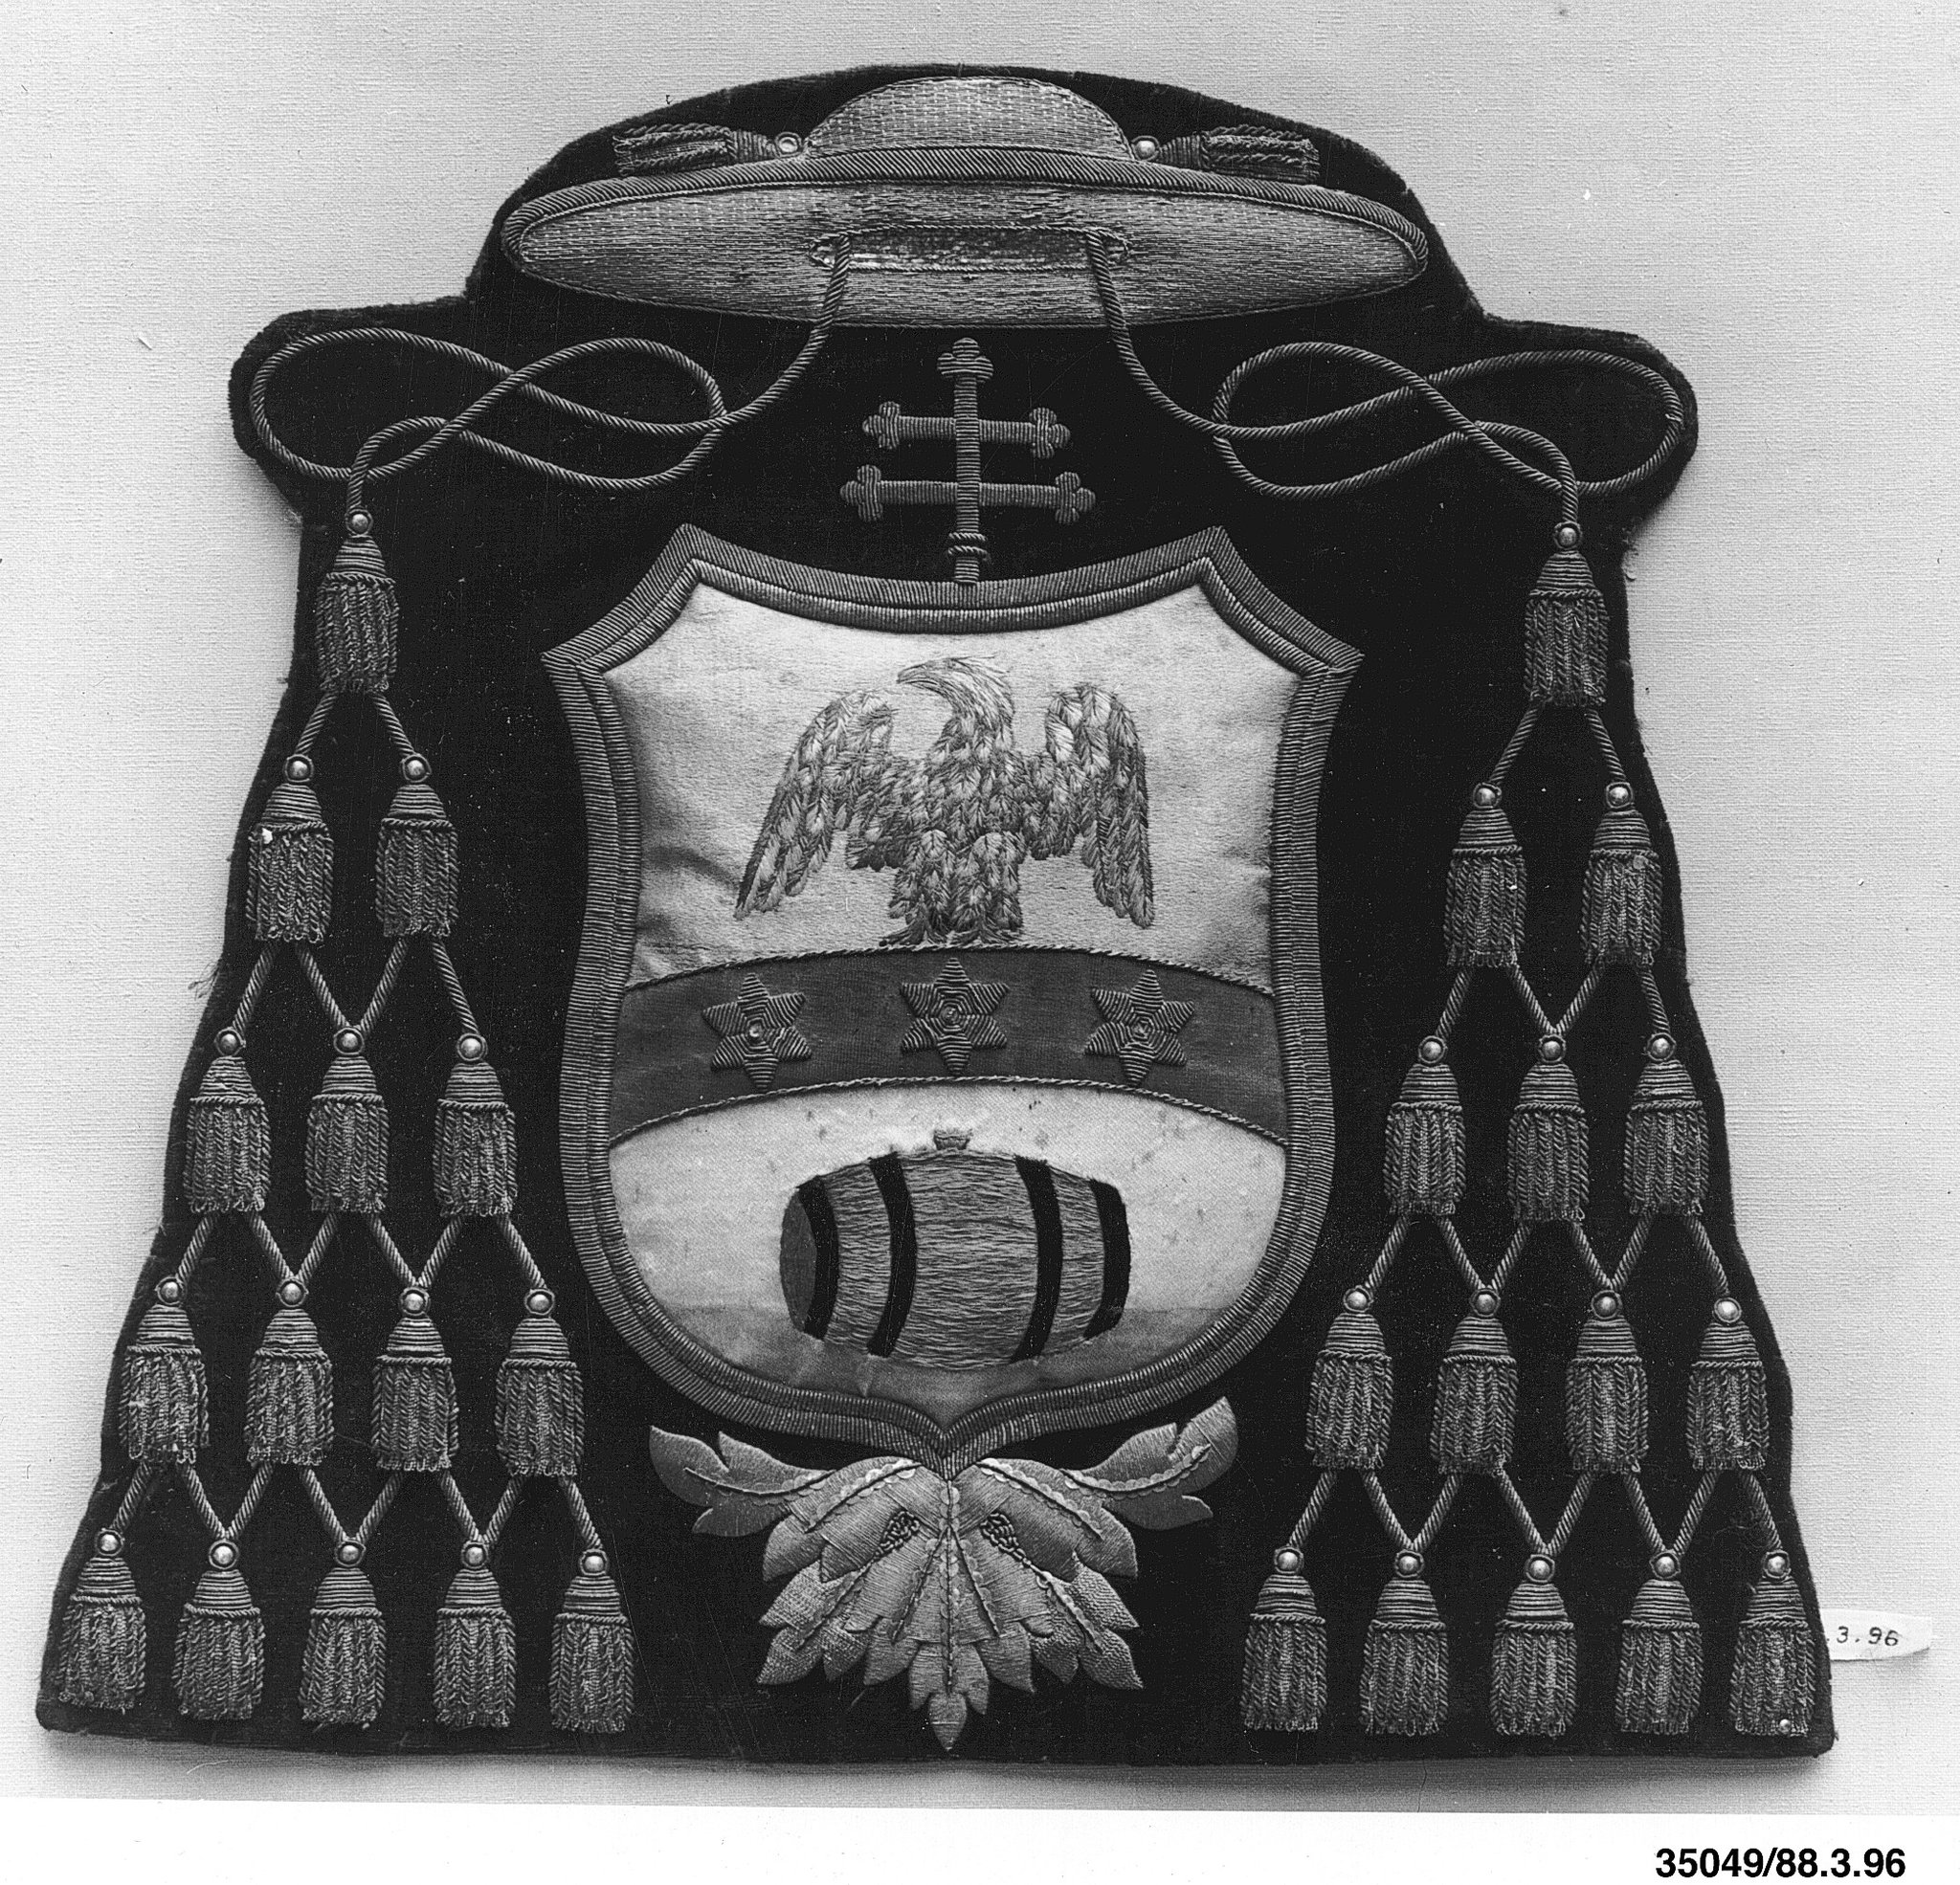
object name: panel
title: Cardinal's armorial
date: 1601-1700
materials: metal thread, silk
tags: eagles,coat of arms